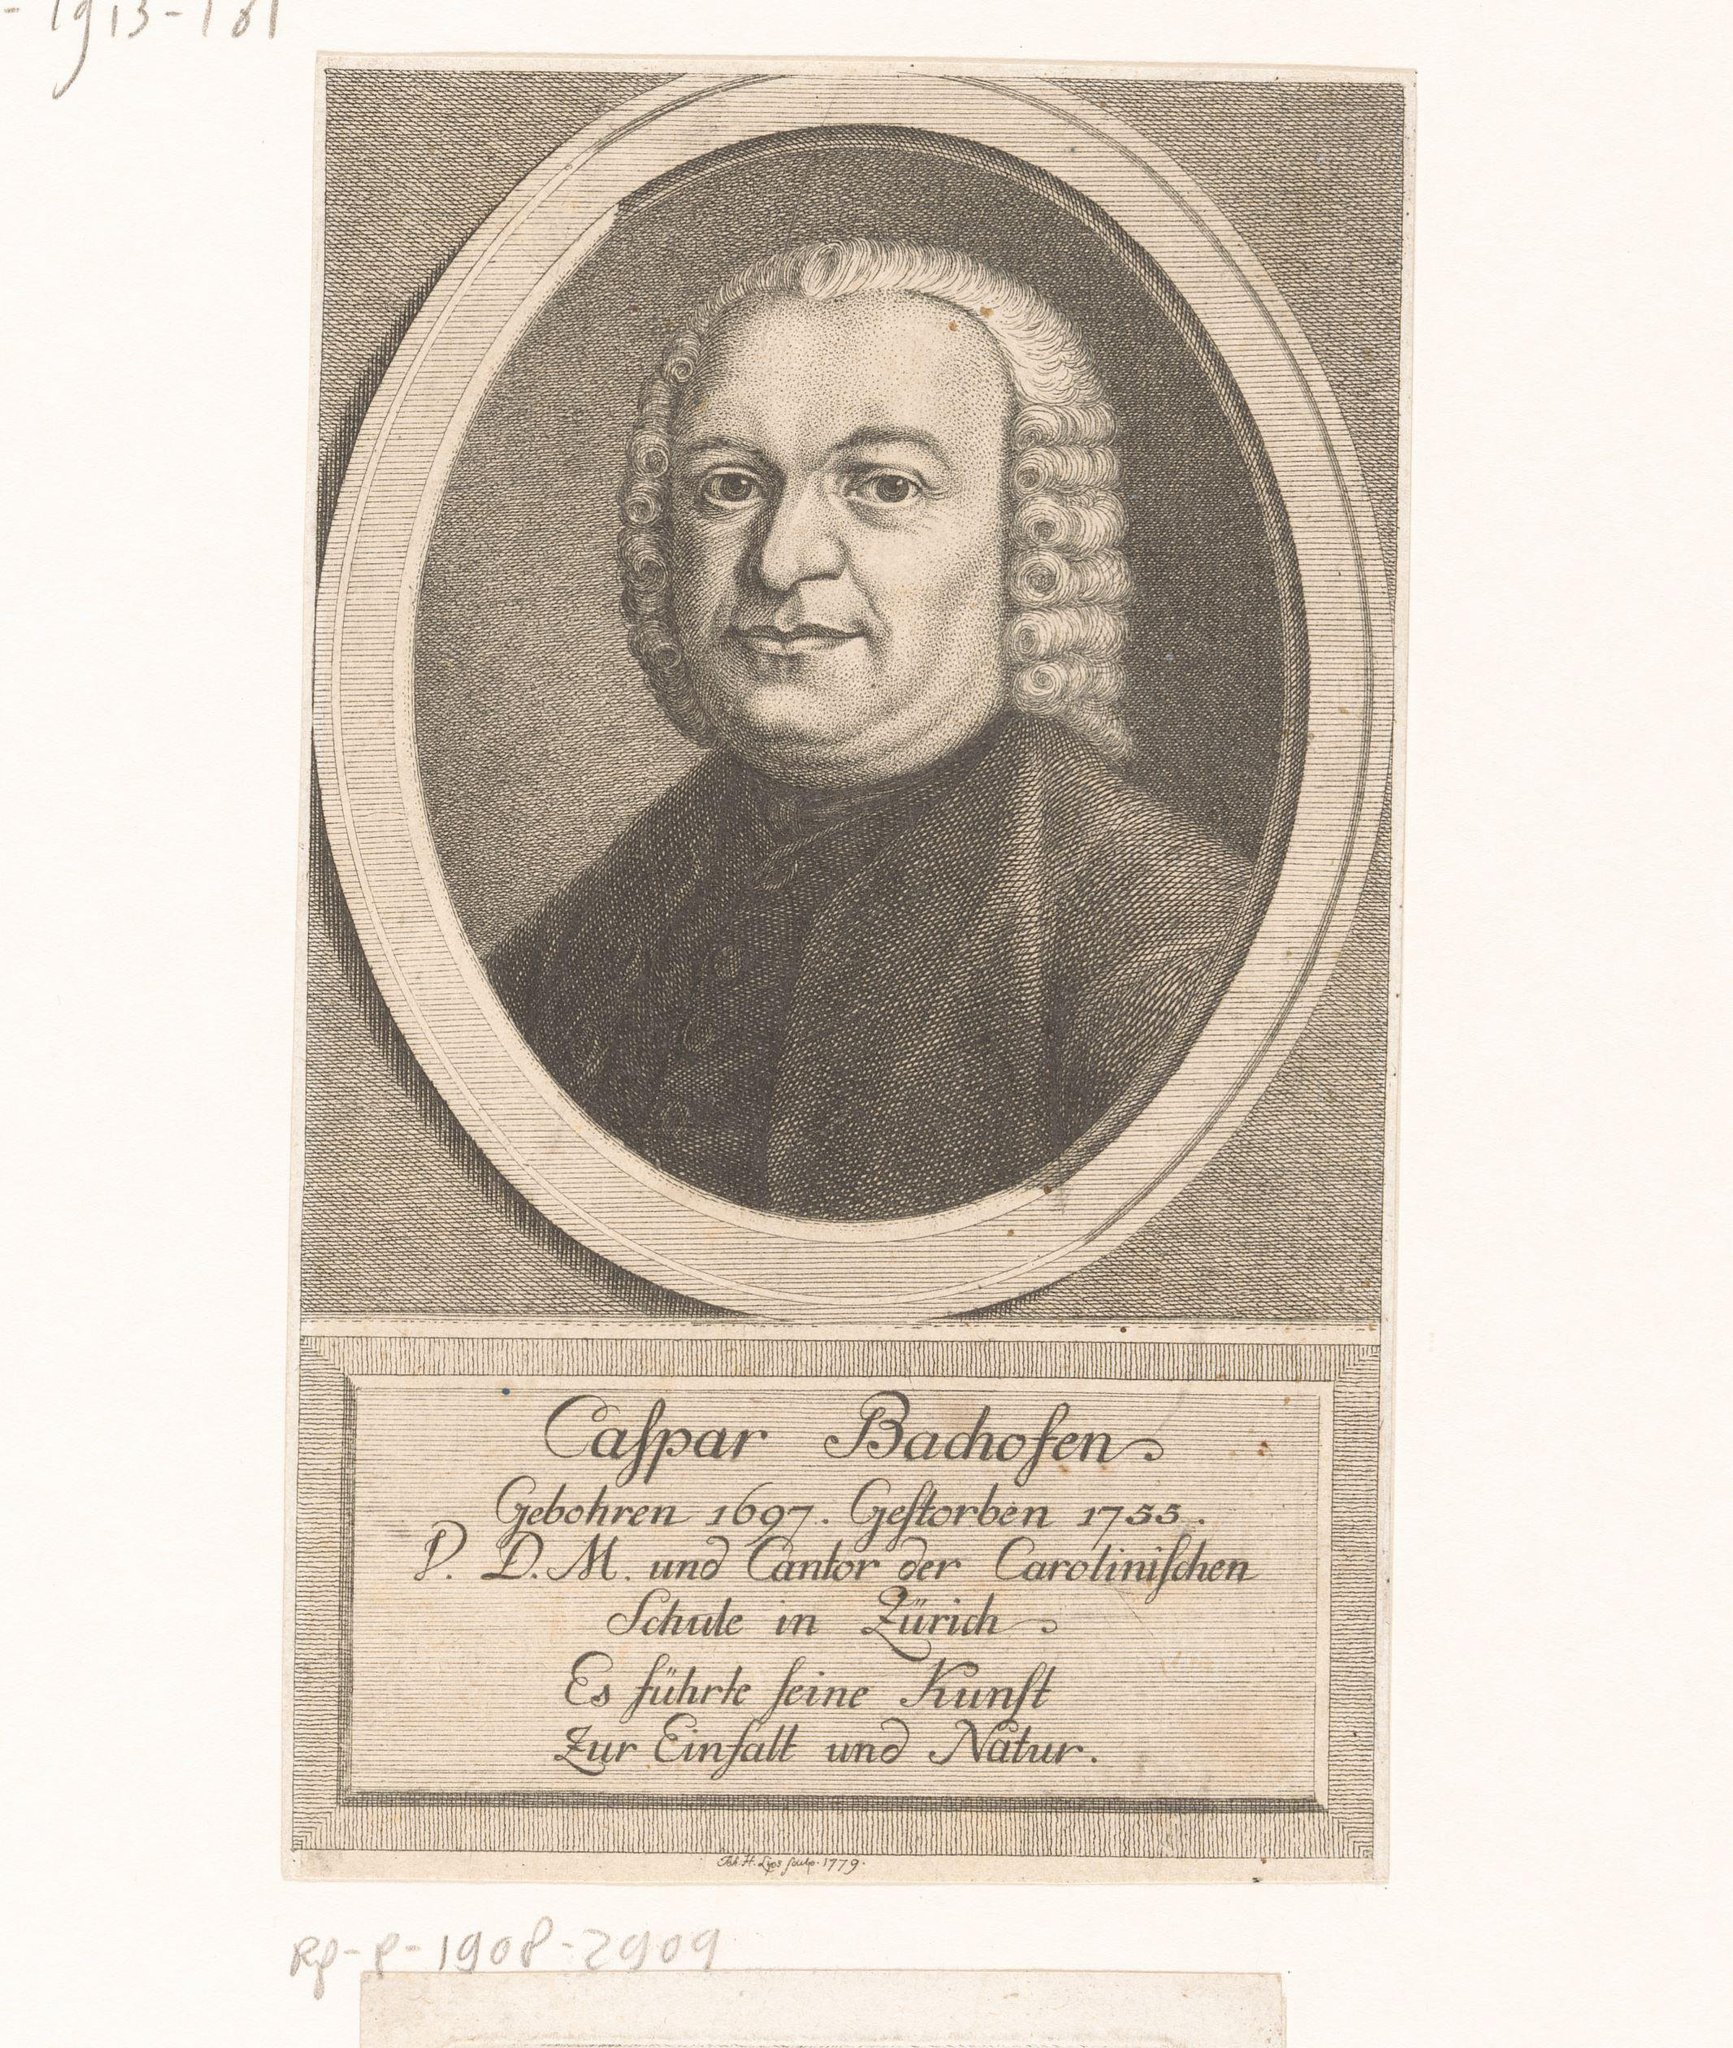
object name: print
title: Portret van Johann Caspar Bachofen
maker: johann heinrich lips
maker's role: draughtsman, painter, print maker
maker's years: 1758-1817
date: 1779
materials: paper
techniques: etching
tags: historical persons, portrait of composer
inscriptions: collector's mark: Lugt 2228